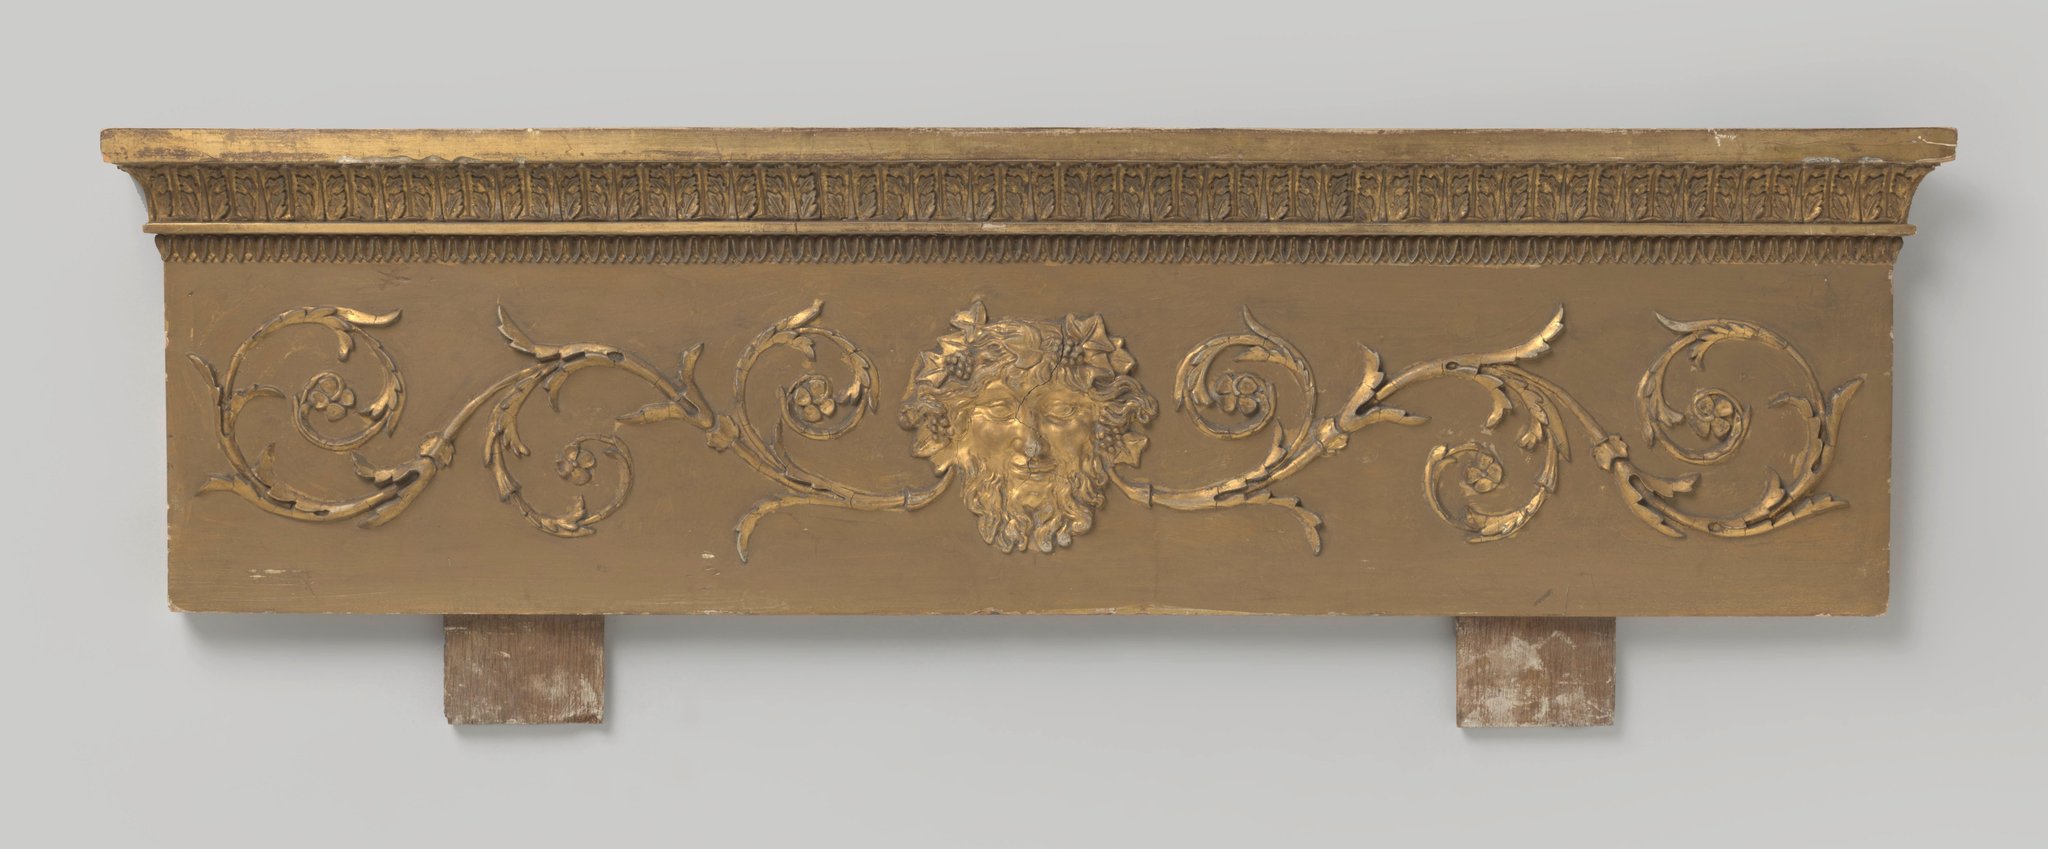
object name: overmantel mirror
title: Opzetstuk van hout, versierd met Bacchuskop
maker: Anonymous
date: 1815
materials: chalk, composition, gold leaf, wood, paint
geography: northern netherlands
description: Opzetstuk van een schoorsteenspiegel, versierd met een Bacchuskop temidden van ranken en bekroond door een lijst met staand acanthusblad.